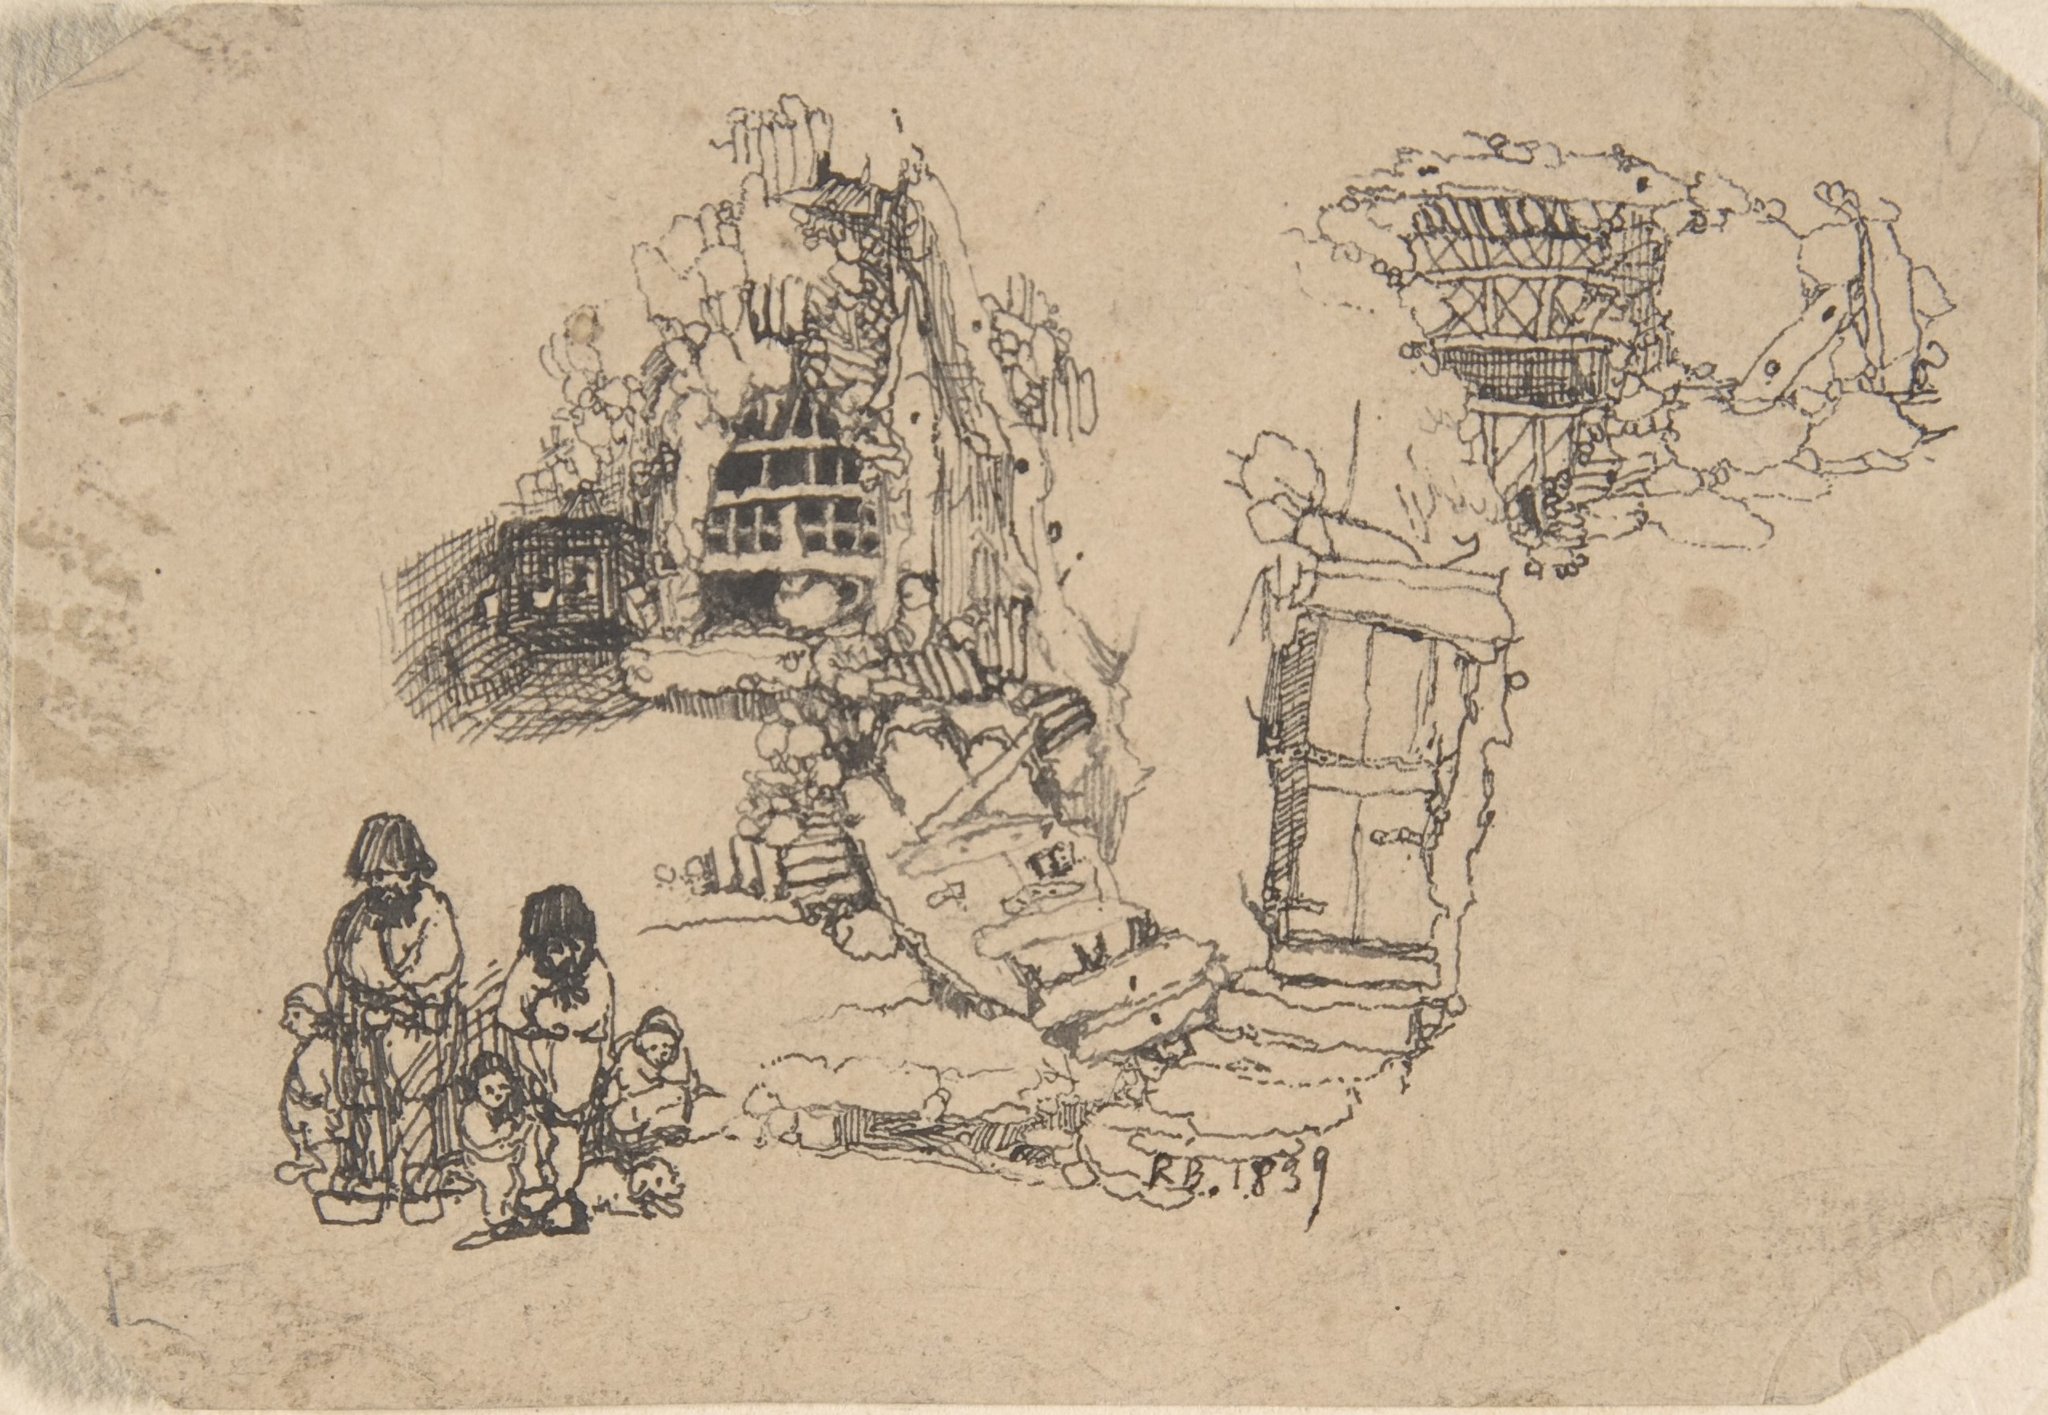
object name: drawing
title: House in the Rocks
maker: rodolphe bresdin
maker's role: artist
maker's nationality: french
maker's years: 1822-1885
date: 1839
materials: ink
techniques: pen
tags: human figures,houses